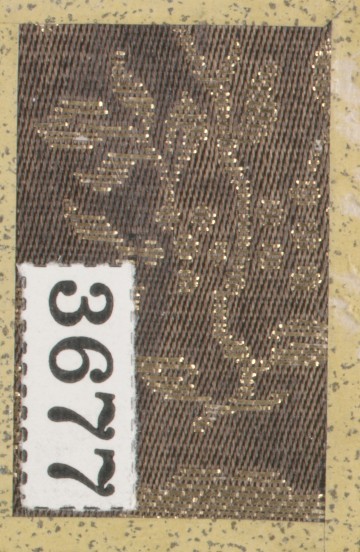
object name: sample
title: Textile Sample from Sample Book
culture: japanese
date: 1801-1900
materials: silk